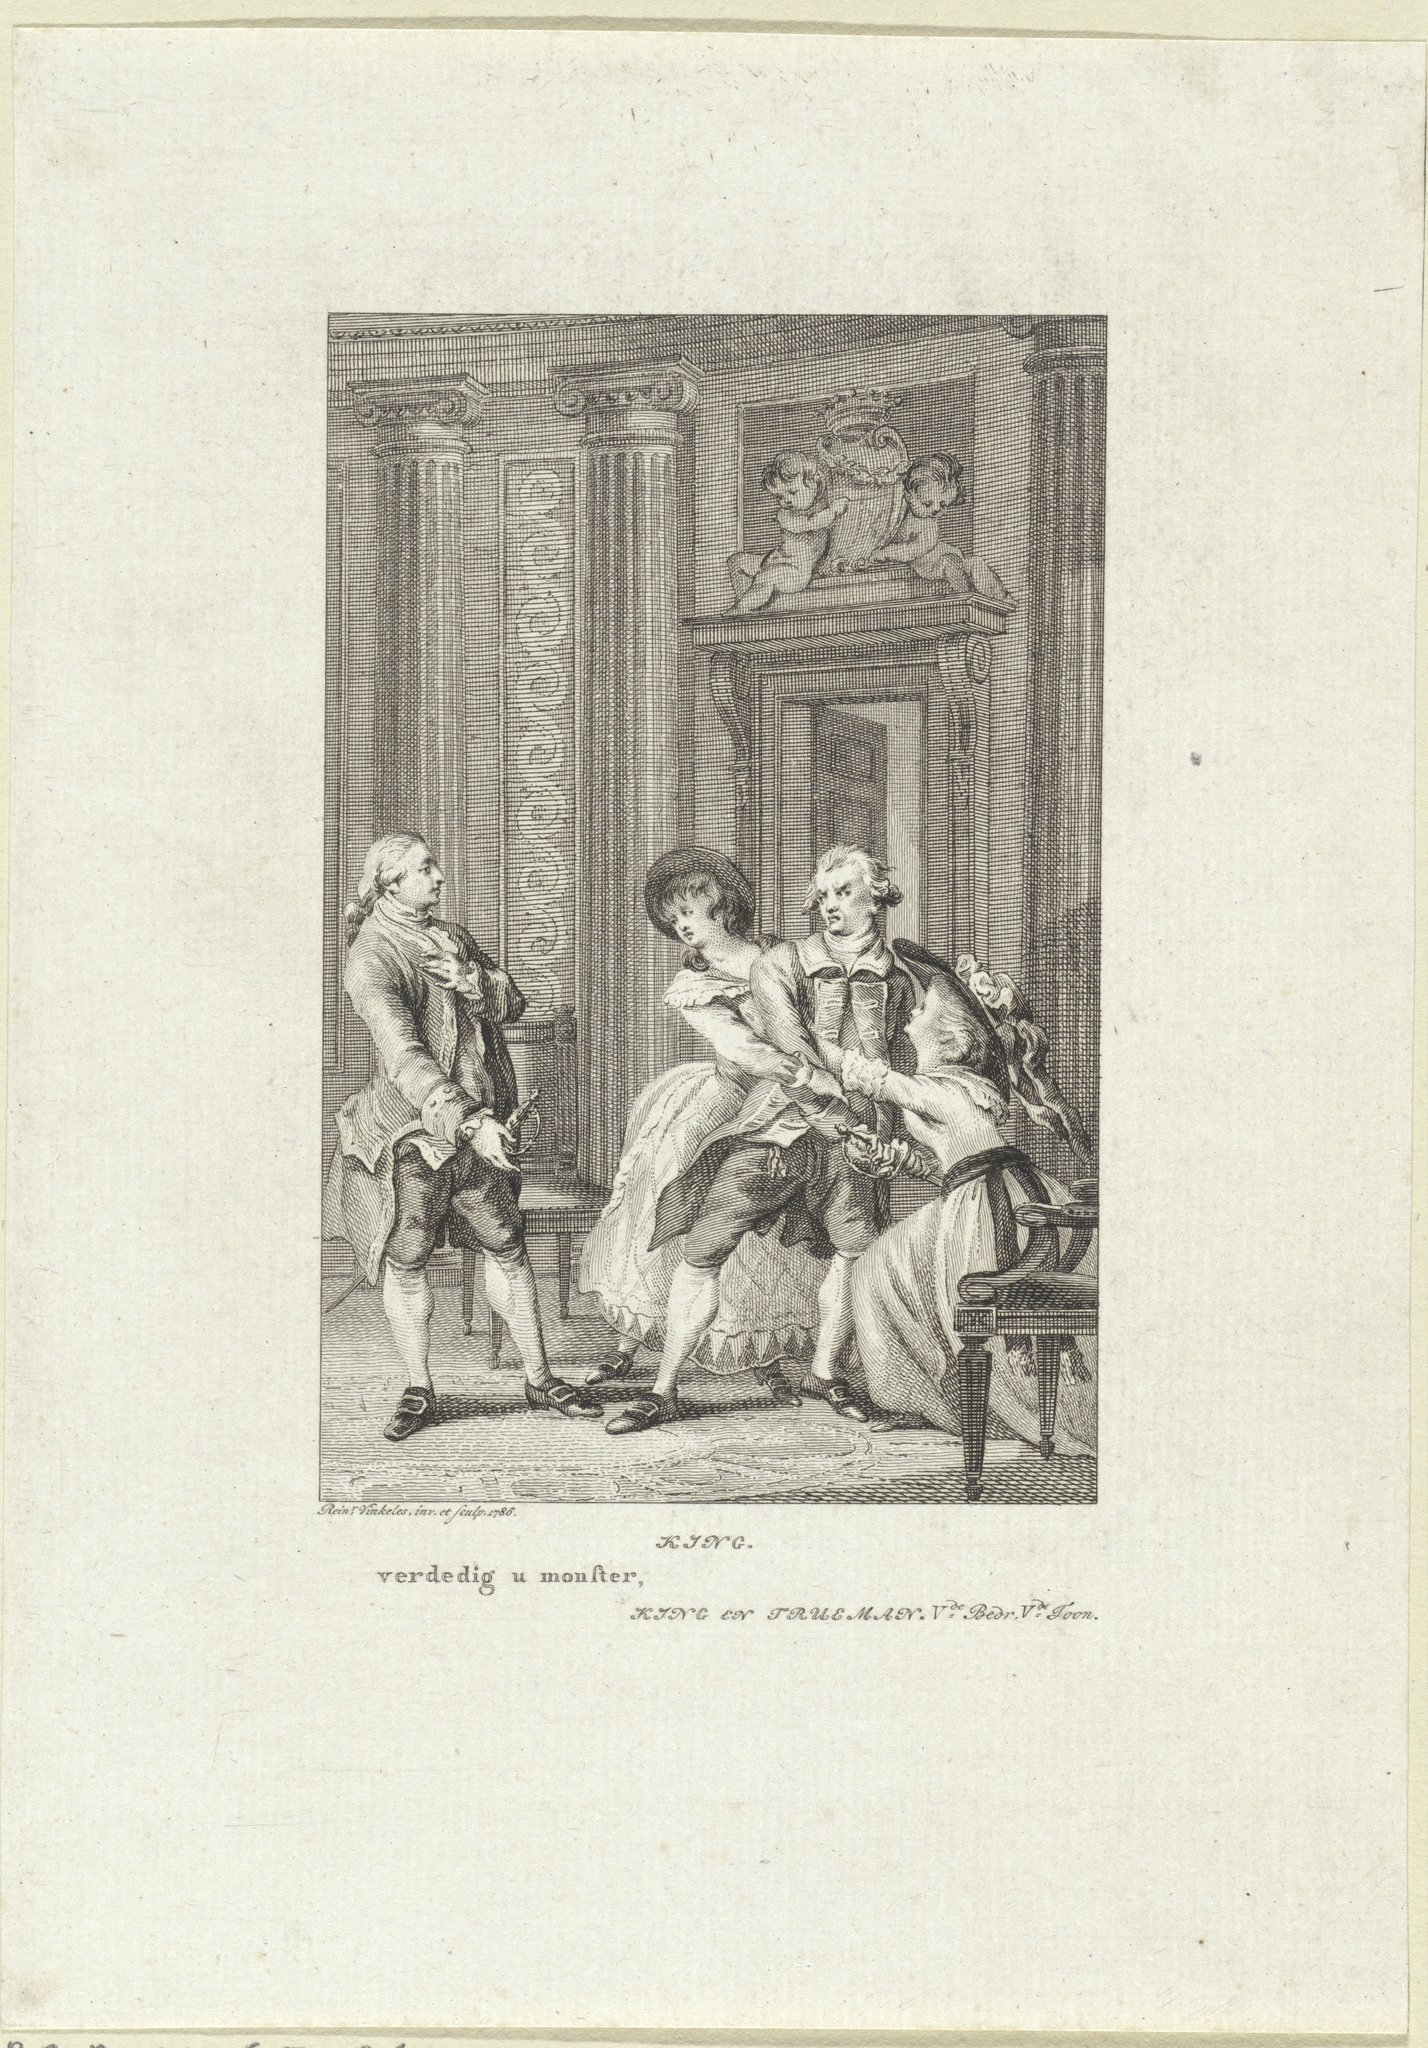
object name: print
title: Heer daagt een ander uit voor een gevecht met de degen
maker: reinier vinkeles (i)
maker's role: draughtsman, print maker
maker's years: 1741-1816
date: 1786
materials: paper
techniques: engraving, etching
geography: amsterdam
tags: hacking and thrusting weapons: sword, threatening behaviour, challenging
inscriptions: collector's mark: Lugt 240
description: Deze prent is mogelijk gebruikt als illustratie voor: King en Trueman, of de menschen-proef. Amsterdam: Erven Pieter Meĳer en Gerrit Warnars, 1786.